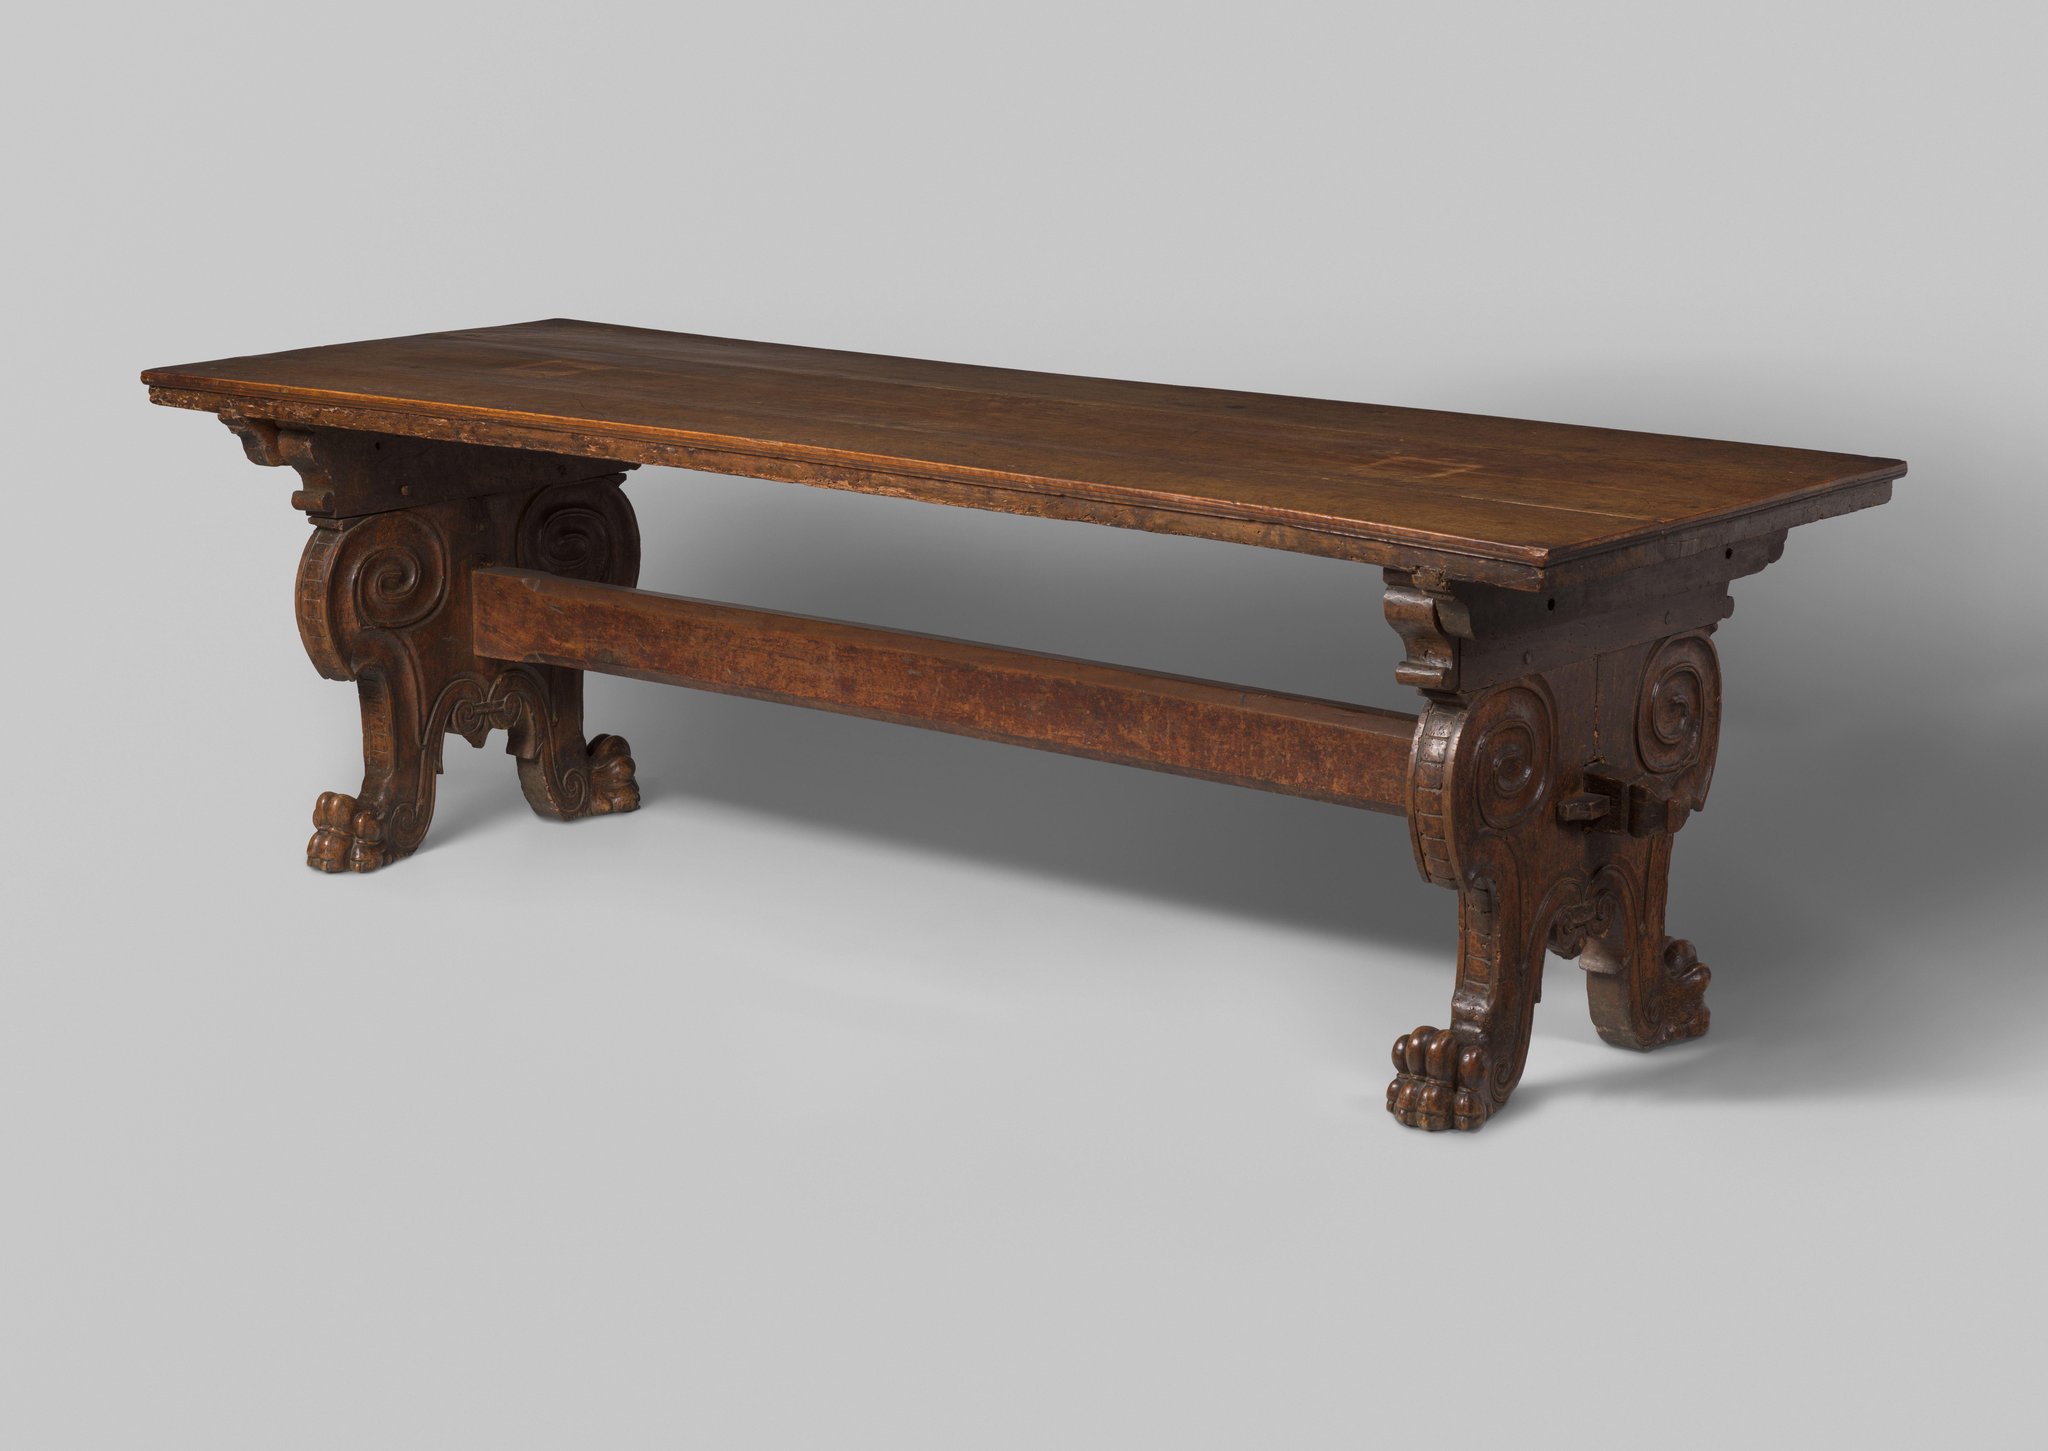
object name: furniture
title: Wangentafel van notenhout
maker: Anonymous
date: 1500-1600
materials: wood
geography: florence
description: Table. Walnut. Italy, 16th century.